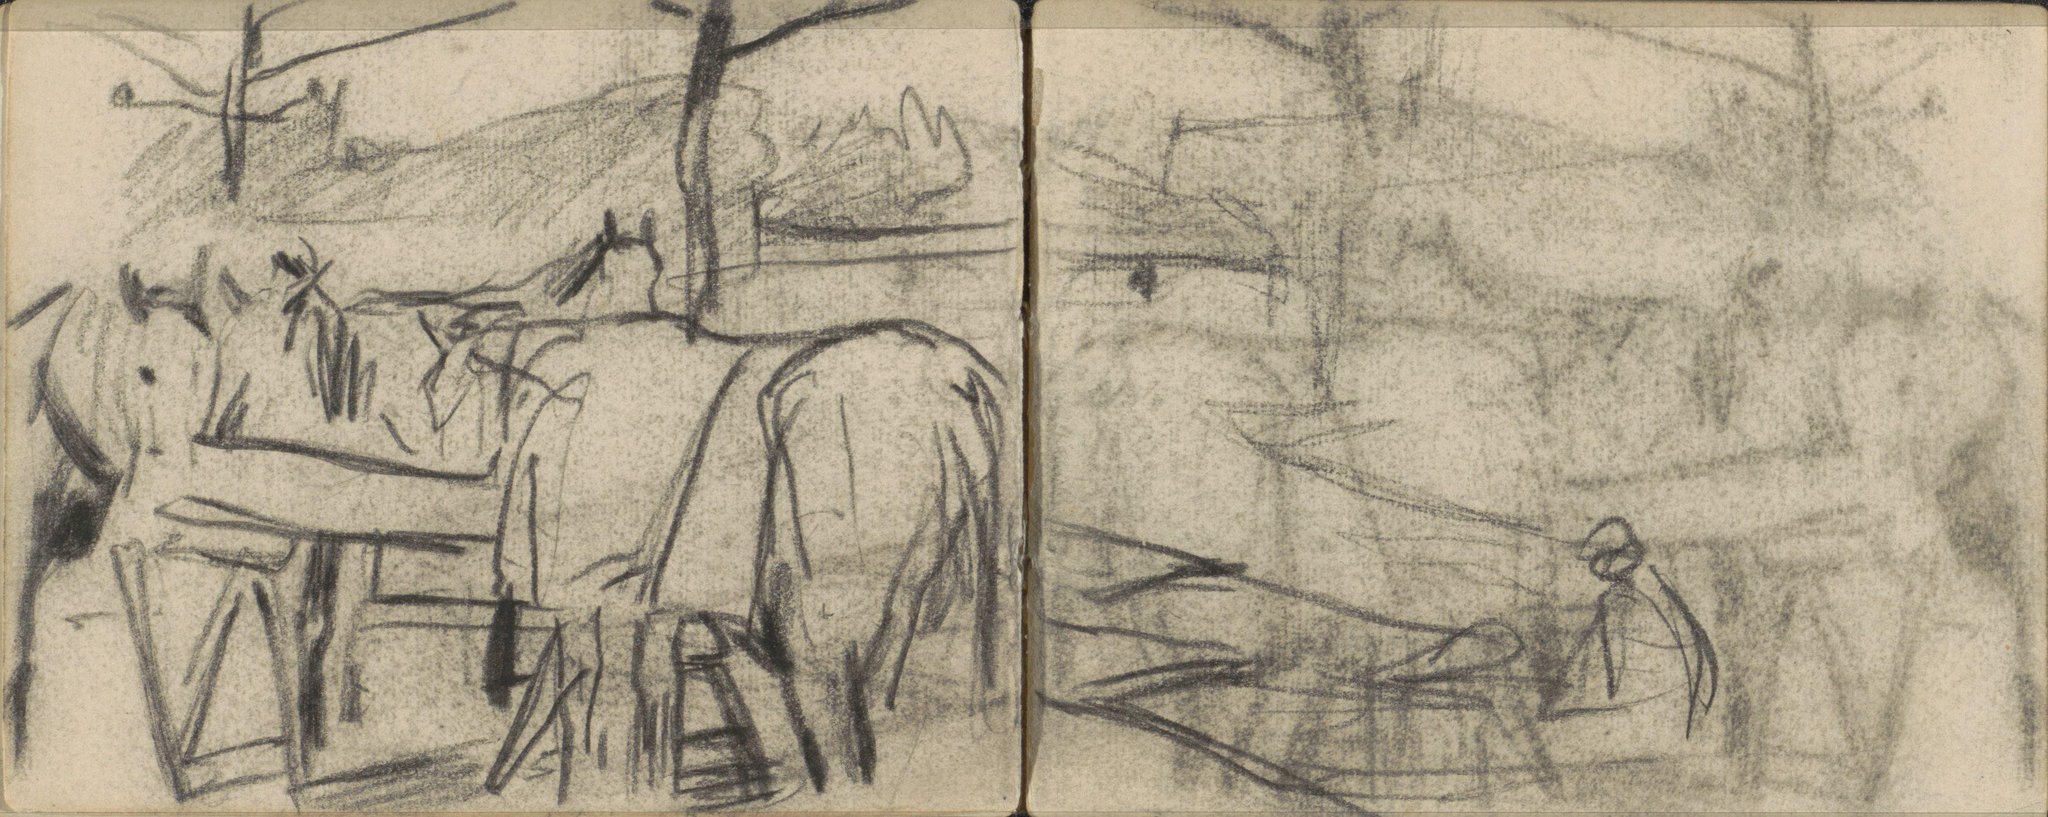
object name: sketchbook leaf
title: Paarden rond een voederbak op de Stadhouderskade te Amsterdam, ter hoogte van het Vondelpark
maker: george hendrik breitner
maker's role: draughtsman, painter, print maker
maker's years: 1857-1923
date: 1886-1895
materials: chalk, paper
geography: amsterdam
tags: horse, giving water, feeding (cattle)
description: Pagina 23 en pagina 24 uit een schetsboek met 34 bladen.